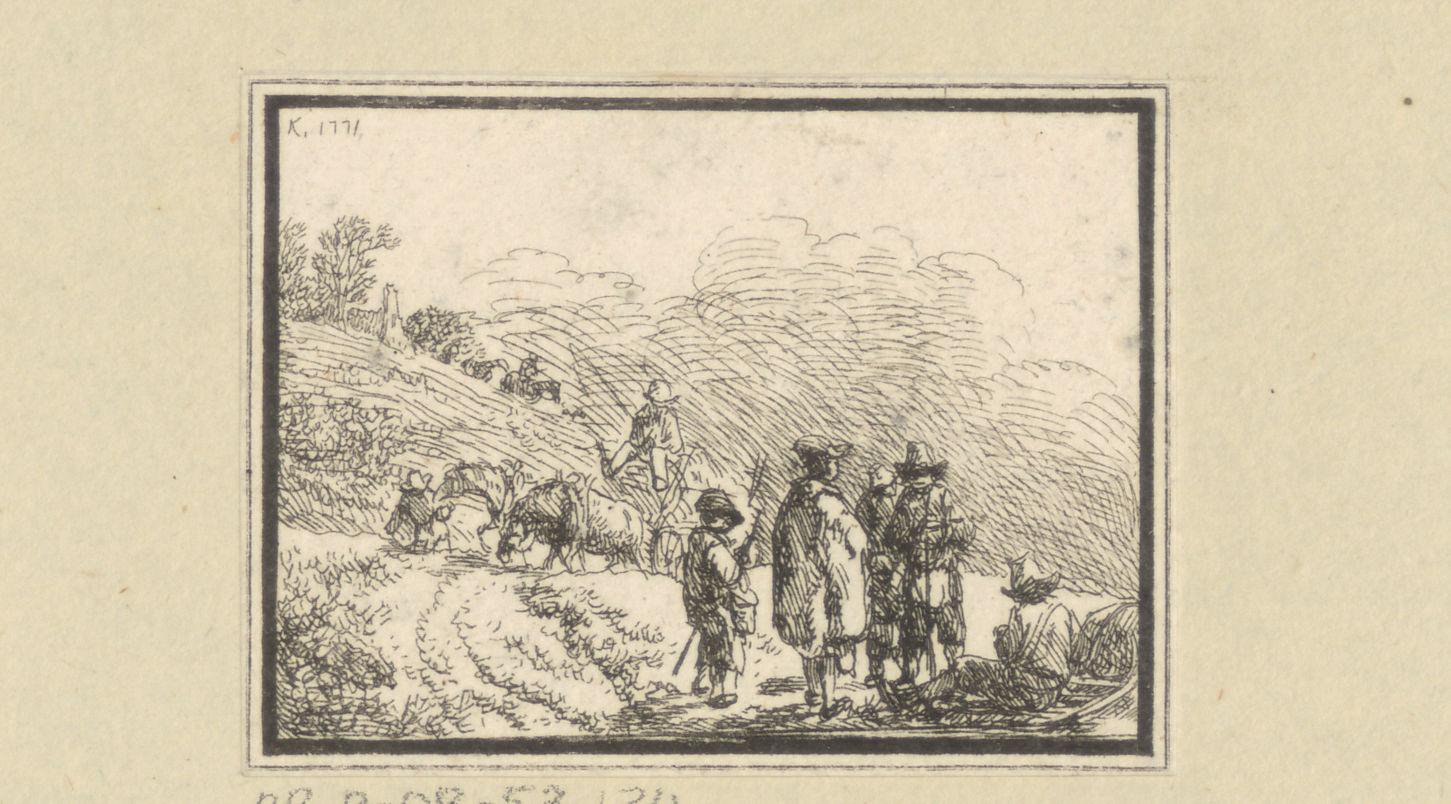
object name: print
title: Landschap met boeren en reizigers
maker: johann christian klengel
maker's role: print maker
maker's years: 1751-1824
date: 1771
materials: paper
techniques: etching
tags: low hill country, cultivation ~ agriculture, 'en route', traveller under way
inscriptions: collector's mark: Lugt 240